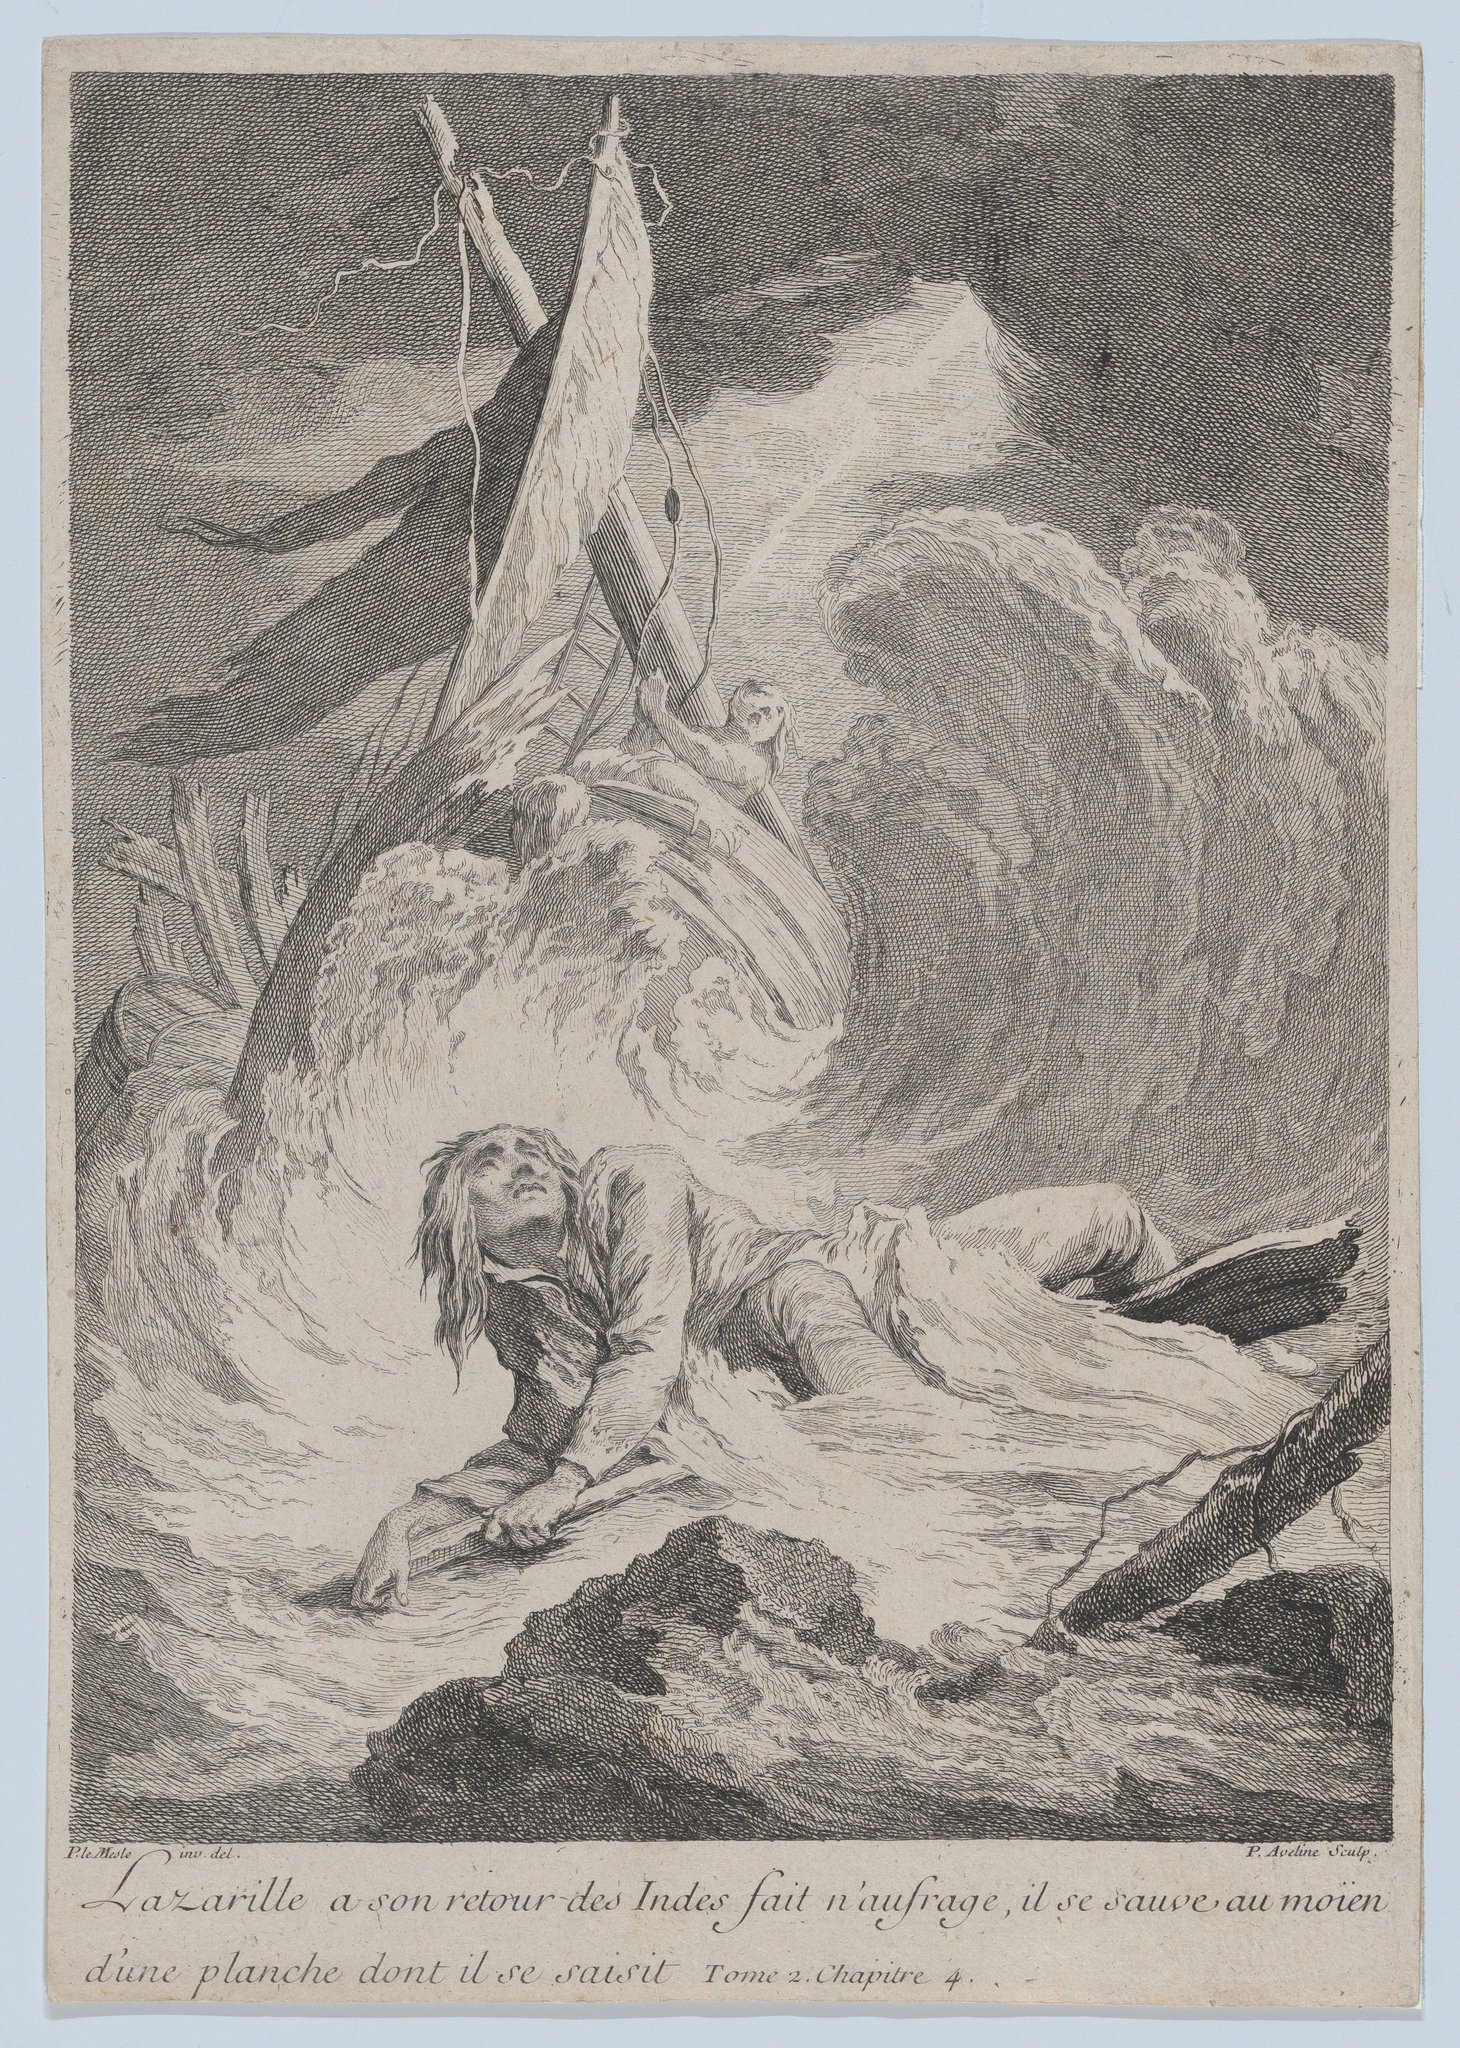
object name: print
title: Lazarille à son retour des Indes fait n'aufrage...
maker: pierre aveline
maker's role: etcher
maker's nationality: french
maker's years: 1679-1722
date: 1717-1760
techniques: engraving, etching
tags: men,storms,ships